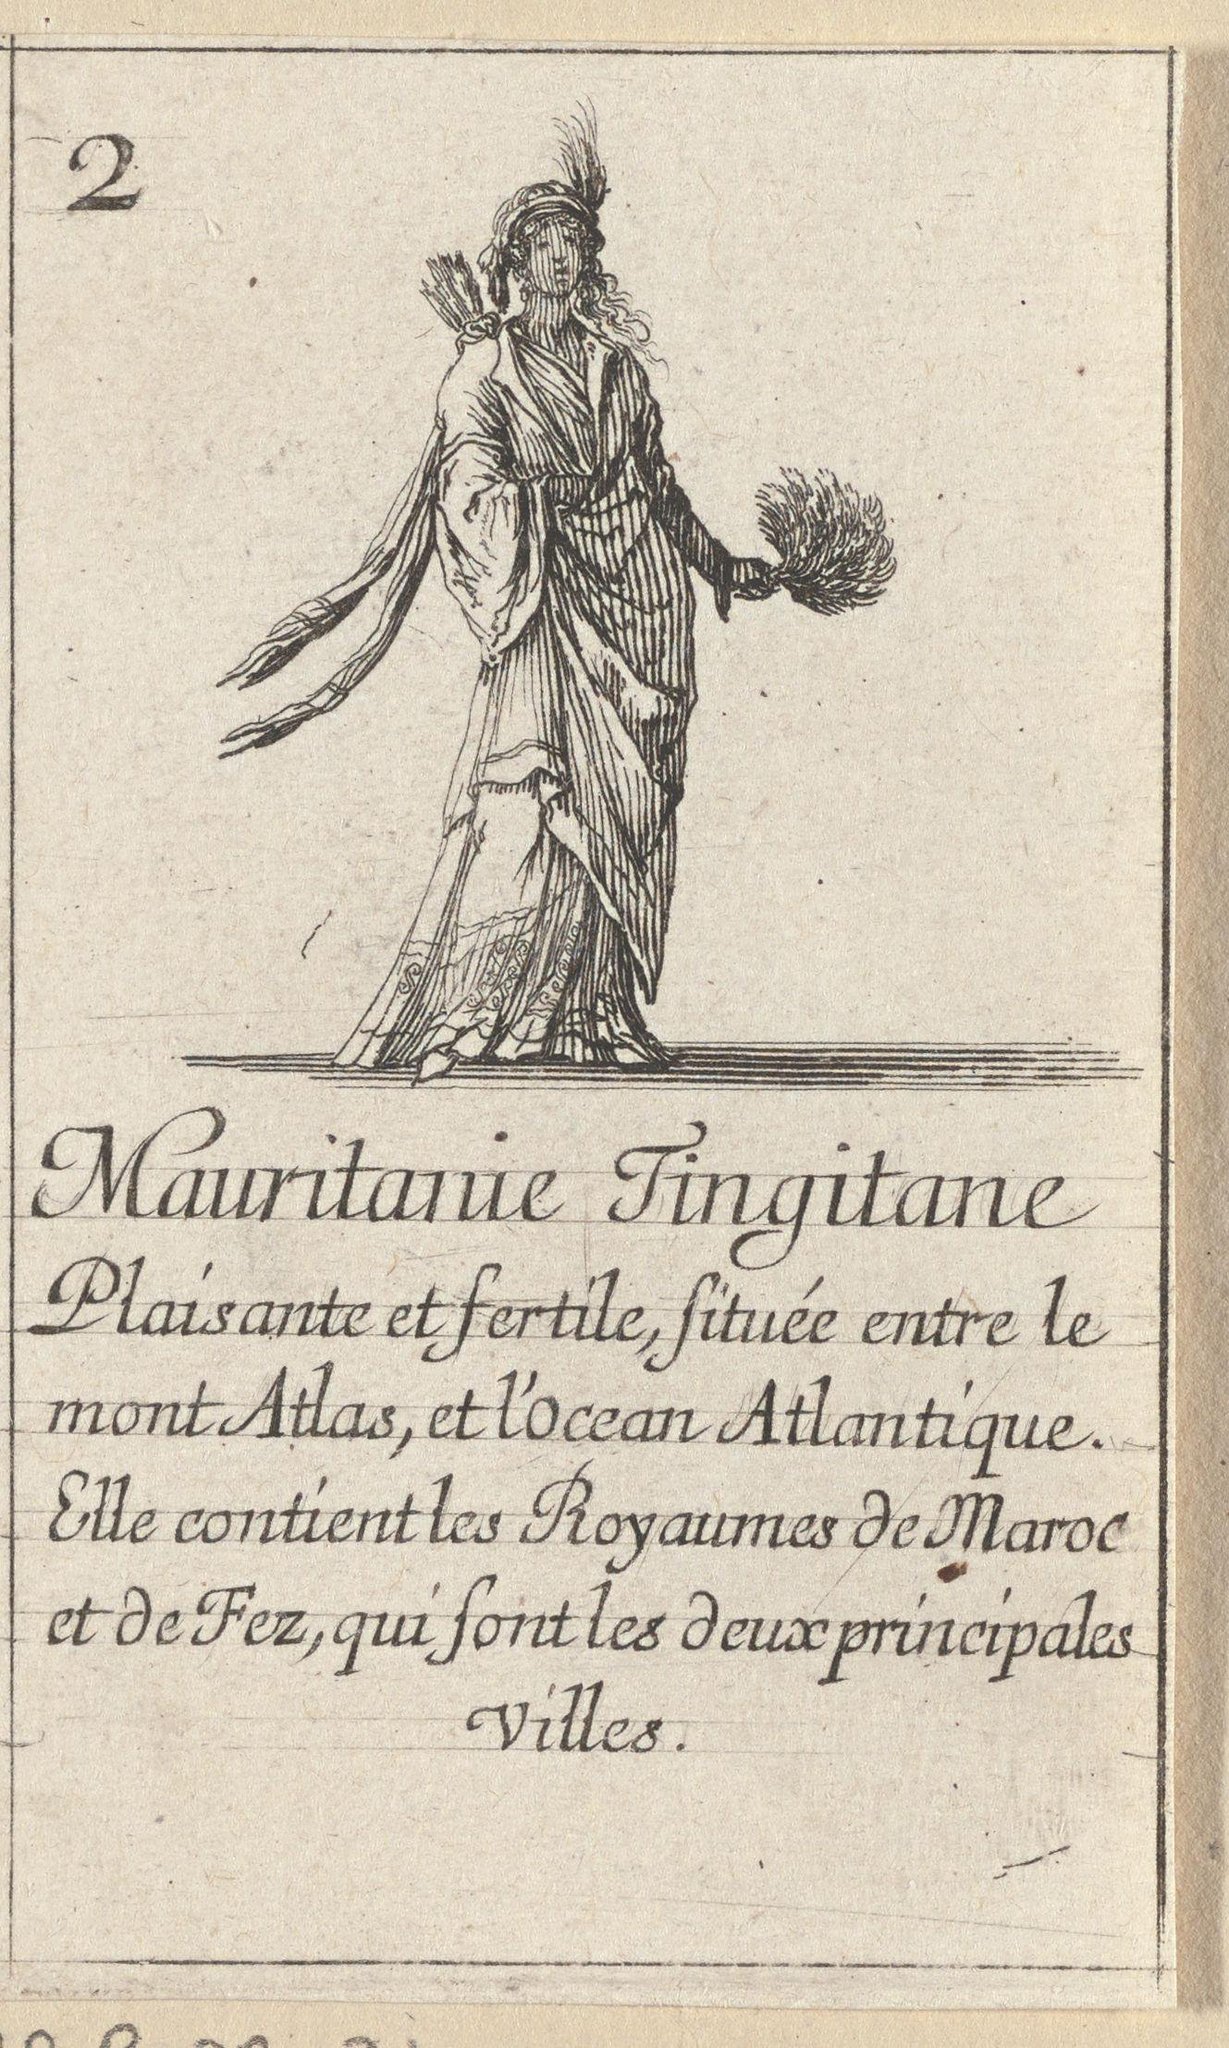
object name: playing card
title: Vrouw uit Mauretania Tingitana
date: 1620-1664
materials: paper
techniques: etching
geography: paris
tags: africans (+ costume)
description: Deze prent maakt deel uit van een kaartspel met 52 kaarten met voorstellingen van vrouwen uit landen over de hele wereld. De serie is uitgedacht door Jean Desmarests de Saint-Sorlin in opdracht van Kardinaal Mazarin. Het kaartspel werd gemaakt voor de jonge Lodewijk XIV, samen met het Jeu des Fables, Jeu des Reynes Renommées en Jeu des Rois de France.